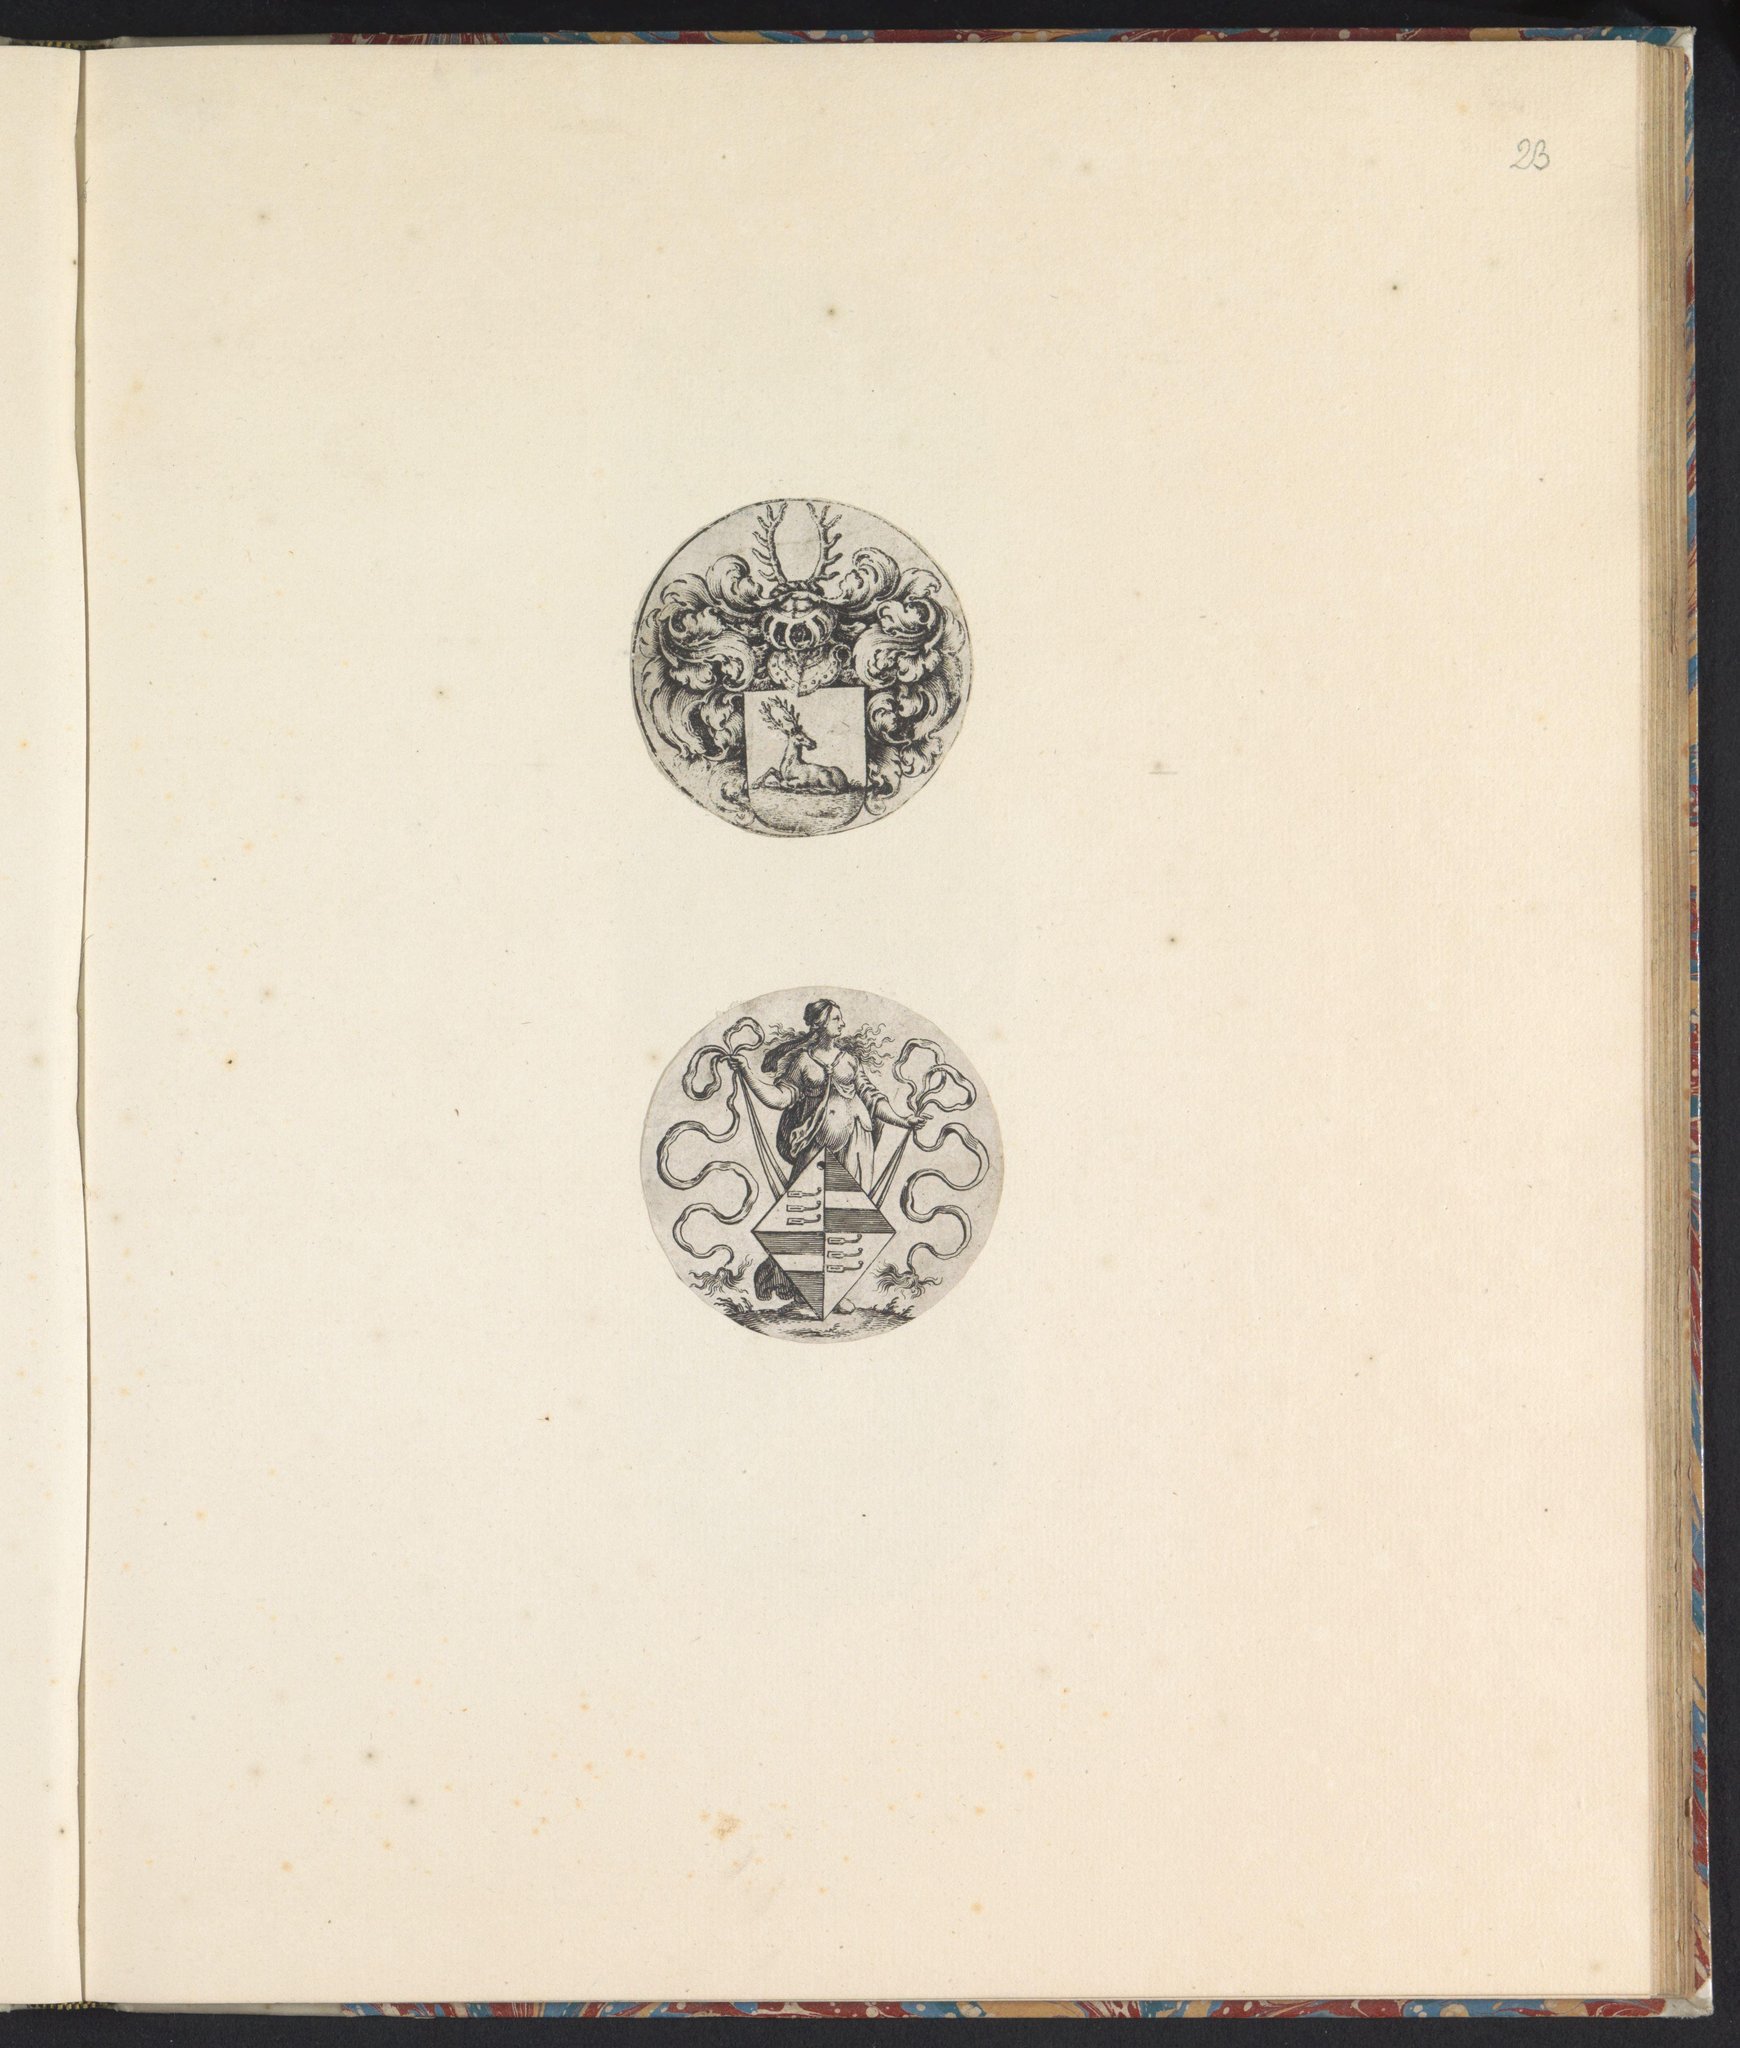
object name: album leaf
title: Twee wapens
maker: Anonymous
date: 1600-1699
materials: paper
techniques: engraving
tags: armorial bearing, heraldry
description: Twee voorstellingen op een albumblad. Bovenaan een wapen met een liggend hert en een gewei als helmteken. Daaronder een vrouw met het wapen van de familie Bicker. De prenten maken deel uit van een album.